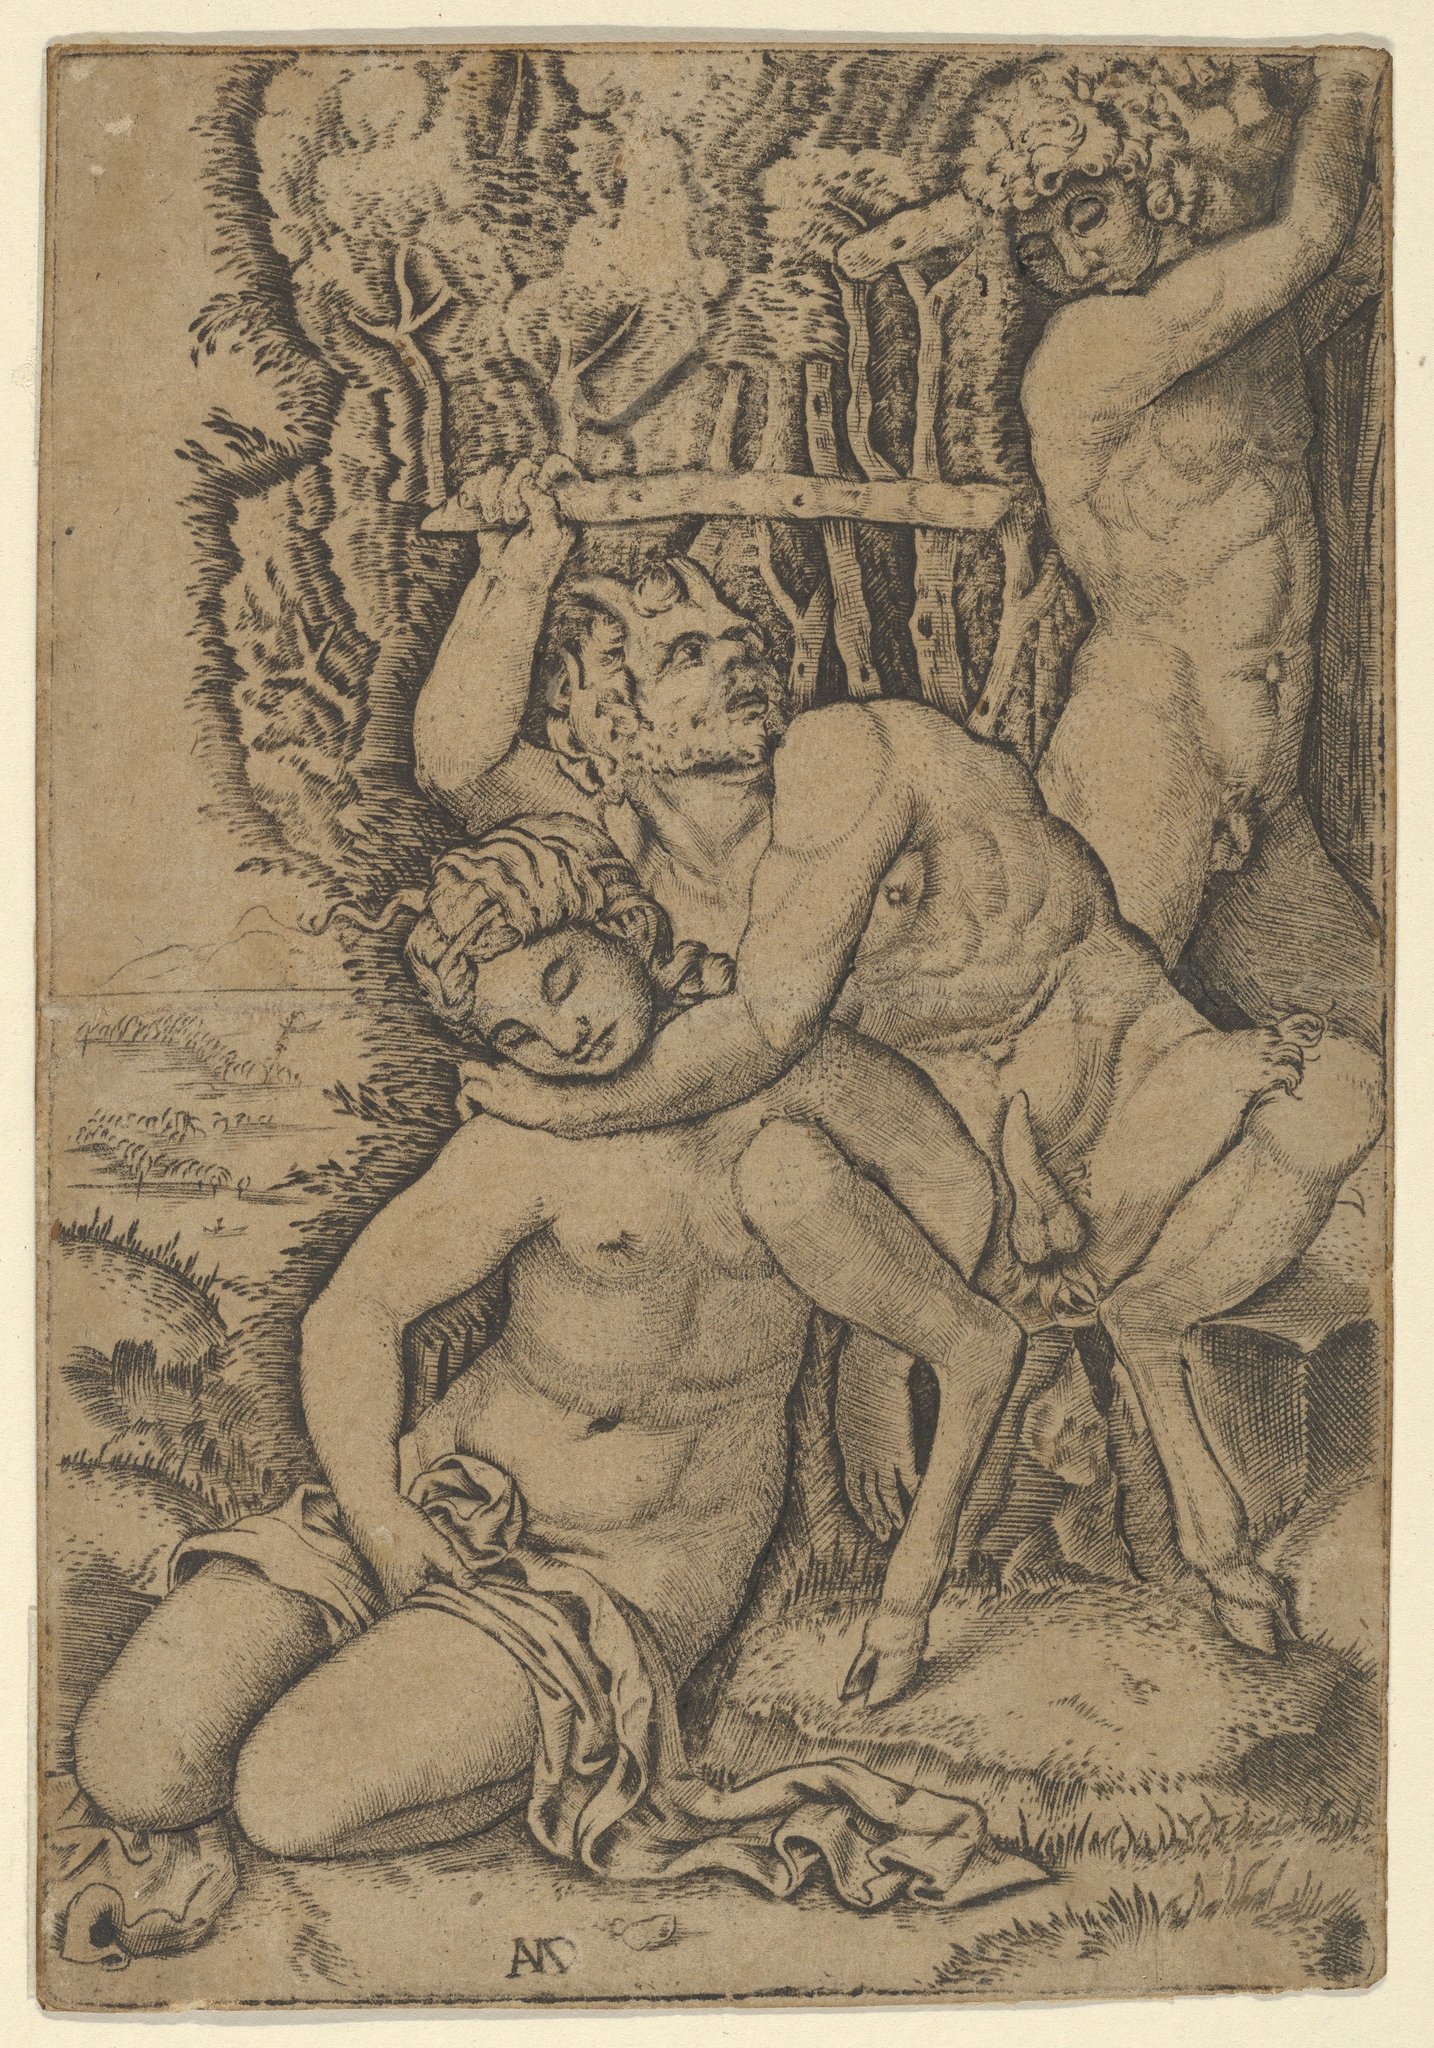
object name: print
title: A satyr fighting for a nymph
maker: marcantonio raimondi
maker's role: artist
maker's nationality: italian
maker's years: 1475-1534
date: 1510-1520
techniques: engraving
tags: male nudes,nymphs,satyrs